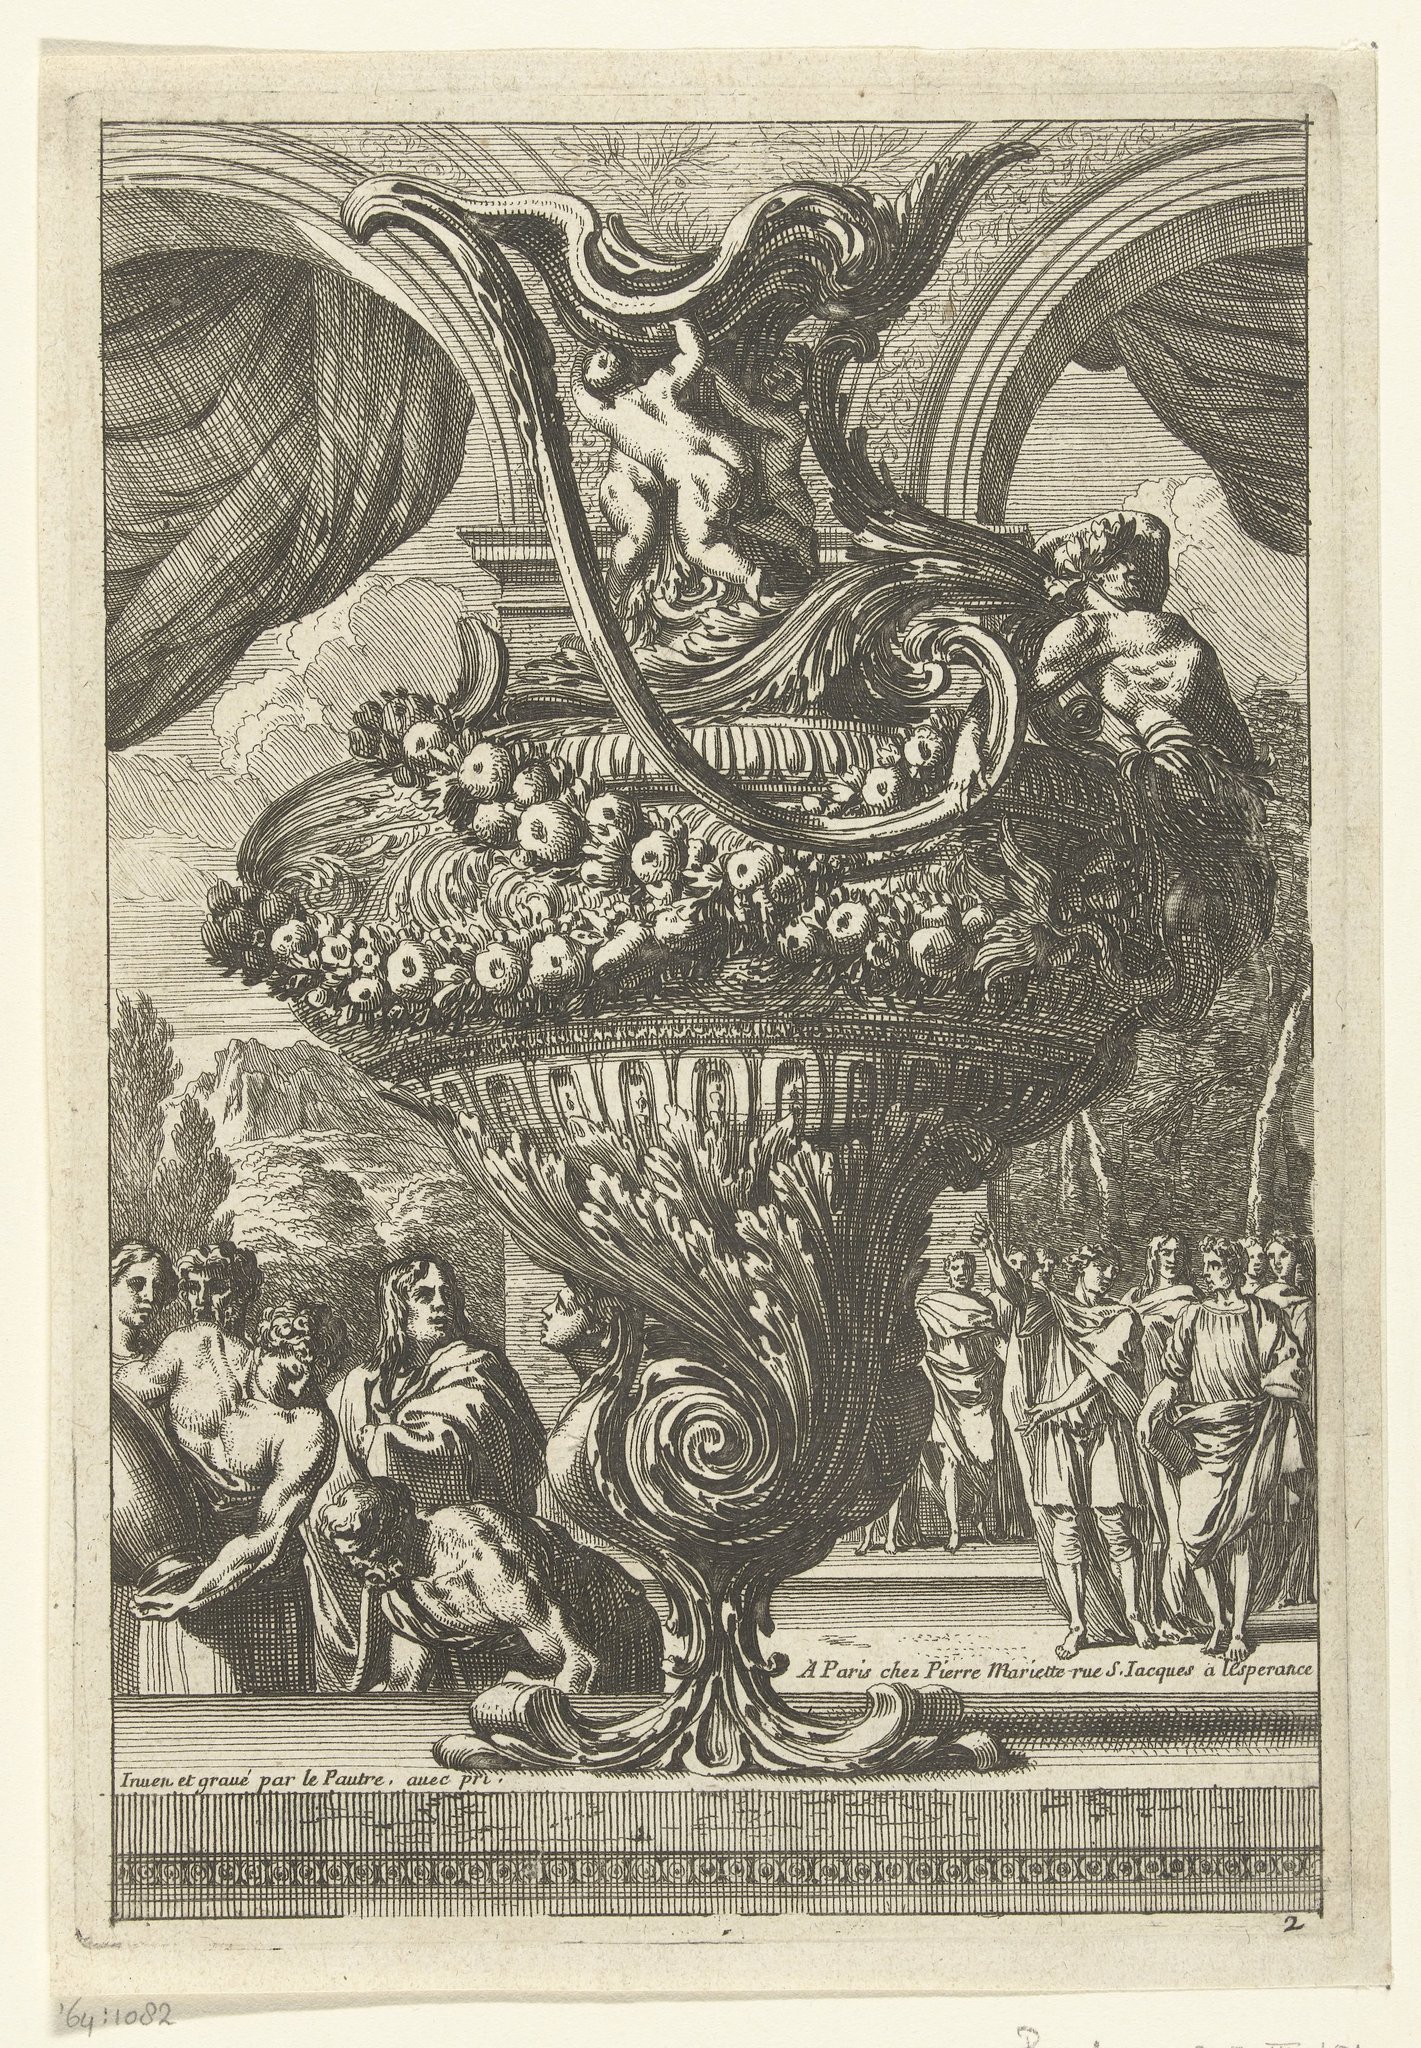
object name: ornament print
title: Vases a l'Antique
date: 1661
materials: paper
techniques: etching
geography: france